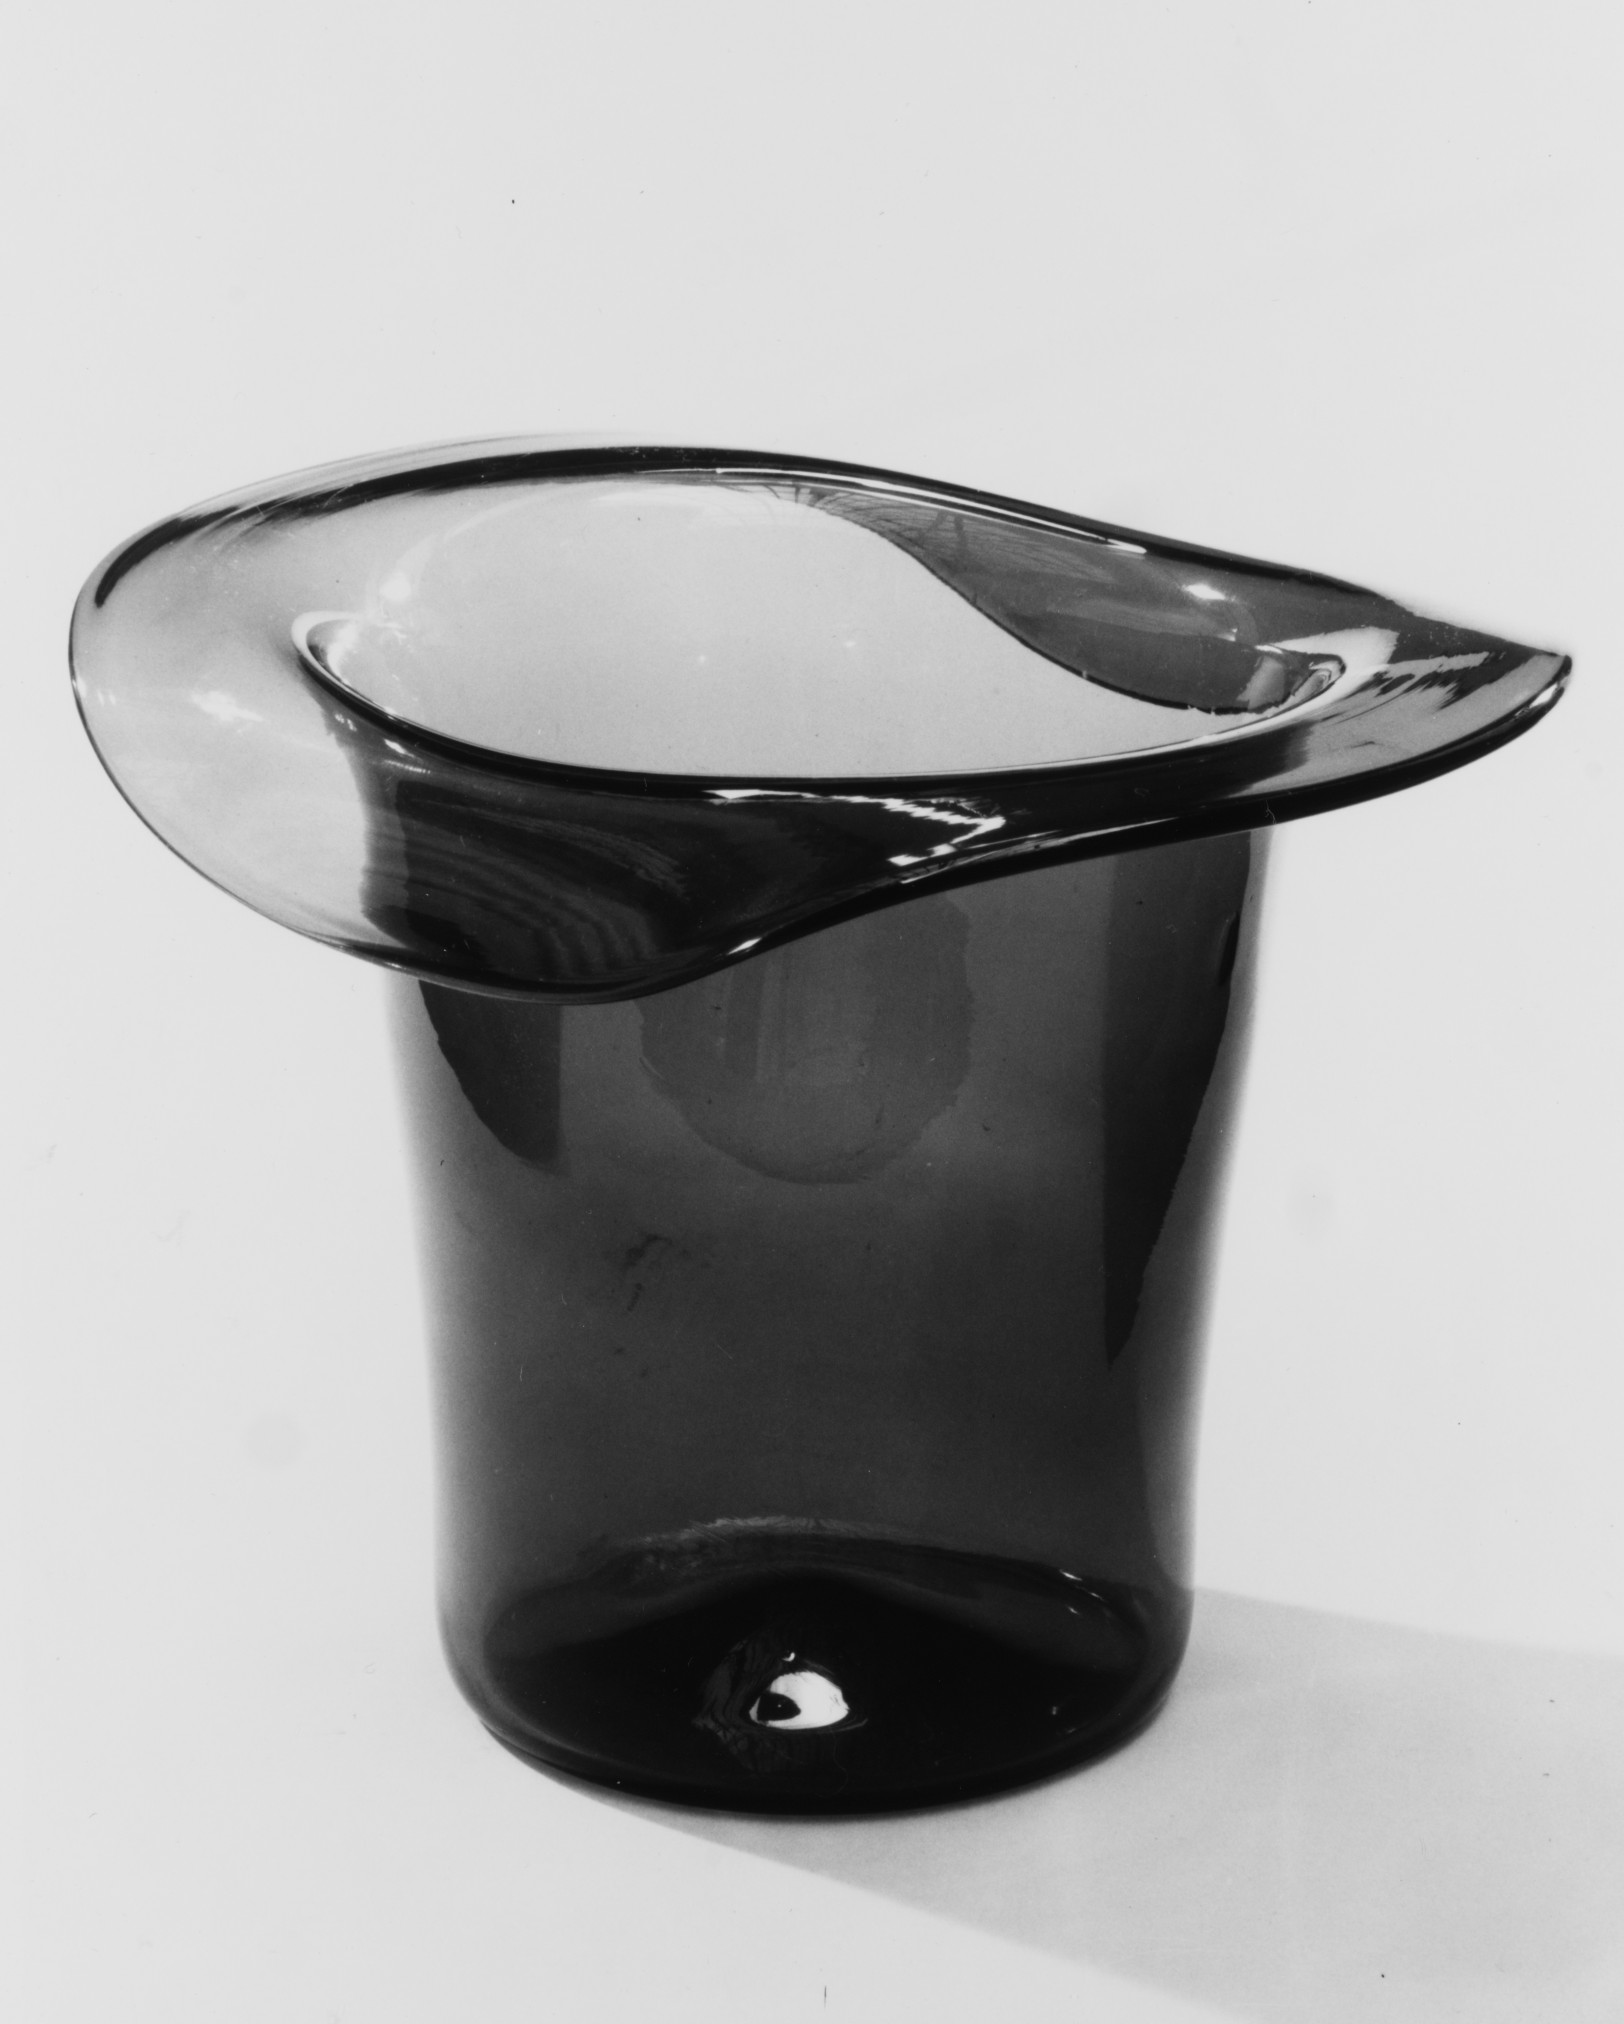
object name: figure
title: Hat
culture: american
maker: dorflinger glass works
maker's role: maker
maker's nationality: american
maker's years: 1865-1881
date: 1865-1921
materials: glass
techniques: glassblowing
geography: united states